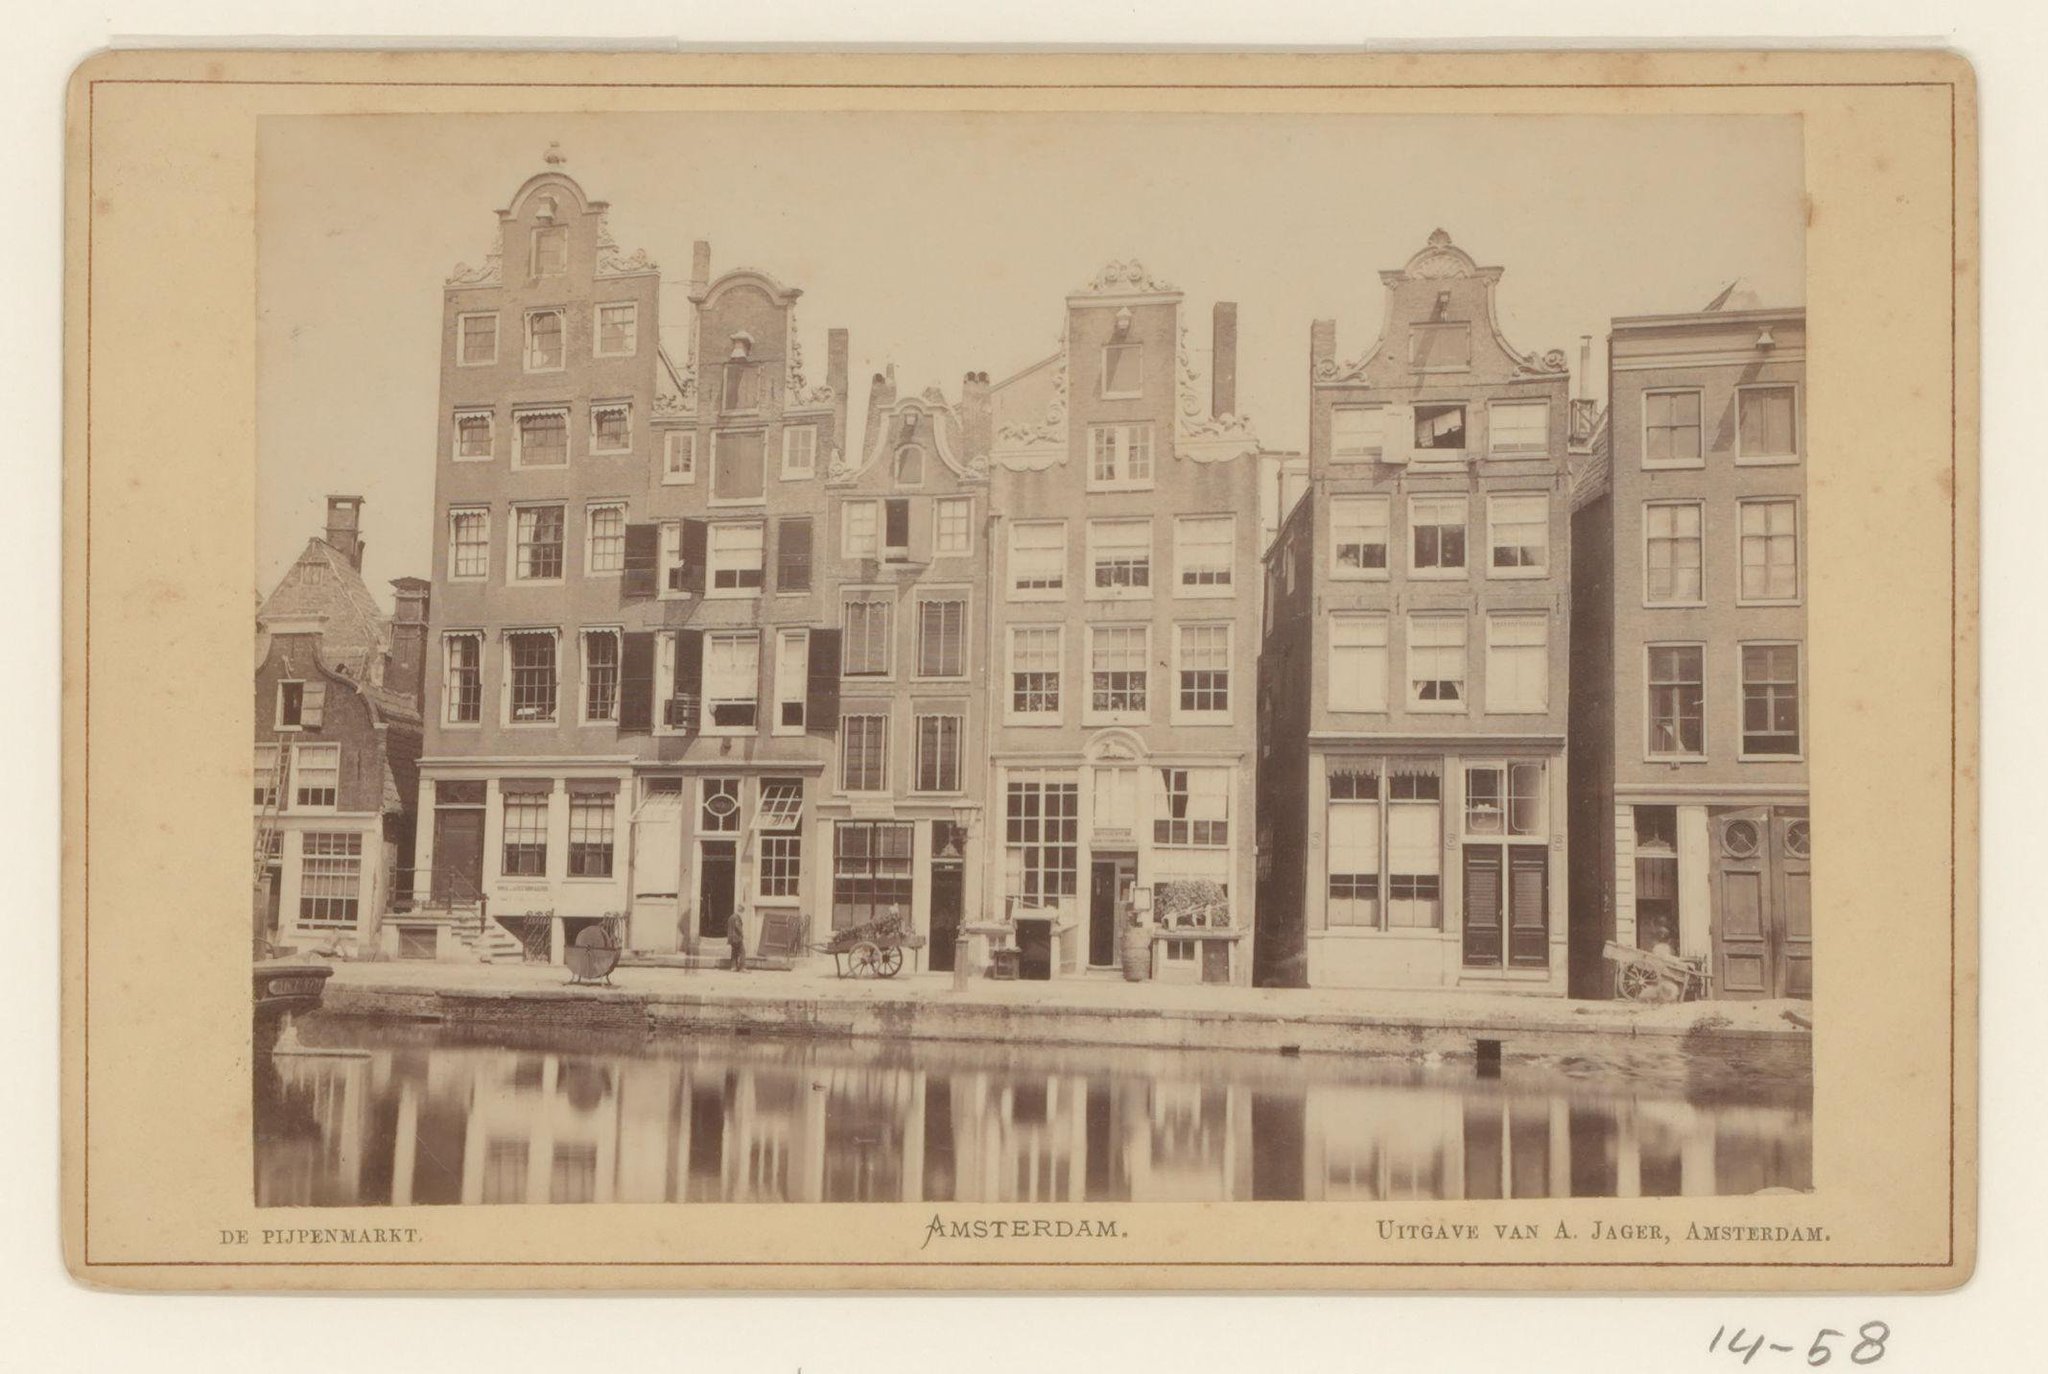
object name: cabinet photograph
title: Gezicht op de Nieuwezijds Voorburgwal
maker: andries jager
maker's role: publisher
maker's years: 1825-1905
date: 1849-1884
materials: cardboard, paper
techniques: albumen print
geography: amsterdam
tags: city-view in general; 'veduta', canal, the usual house or row of houses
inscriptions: collector's mark: ‘14.58’ Lugt 1641b, inscription: ‘De Pijpenmarkt (N.Z. Voorb.) / 44.’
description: Onderwerpsrubriek binnen de Atlas Amsterdam: Verhulststraat (Johannes), Viaducten, Vierwindenstraat, Vinkenbuurt, Vinkenpad, Vinkenstraat, Vischsteeg, Vliegendesteeg, Voetboogstraat, Volewijk, Vondelstraat, Voorburgwal (N.Z.).